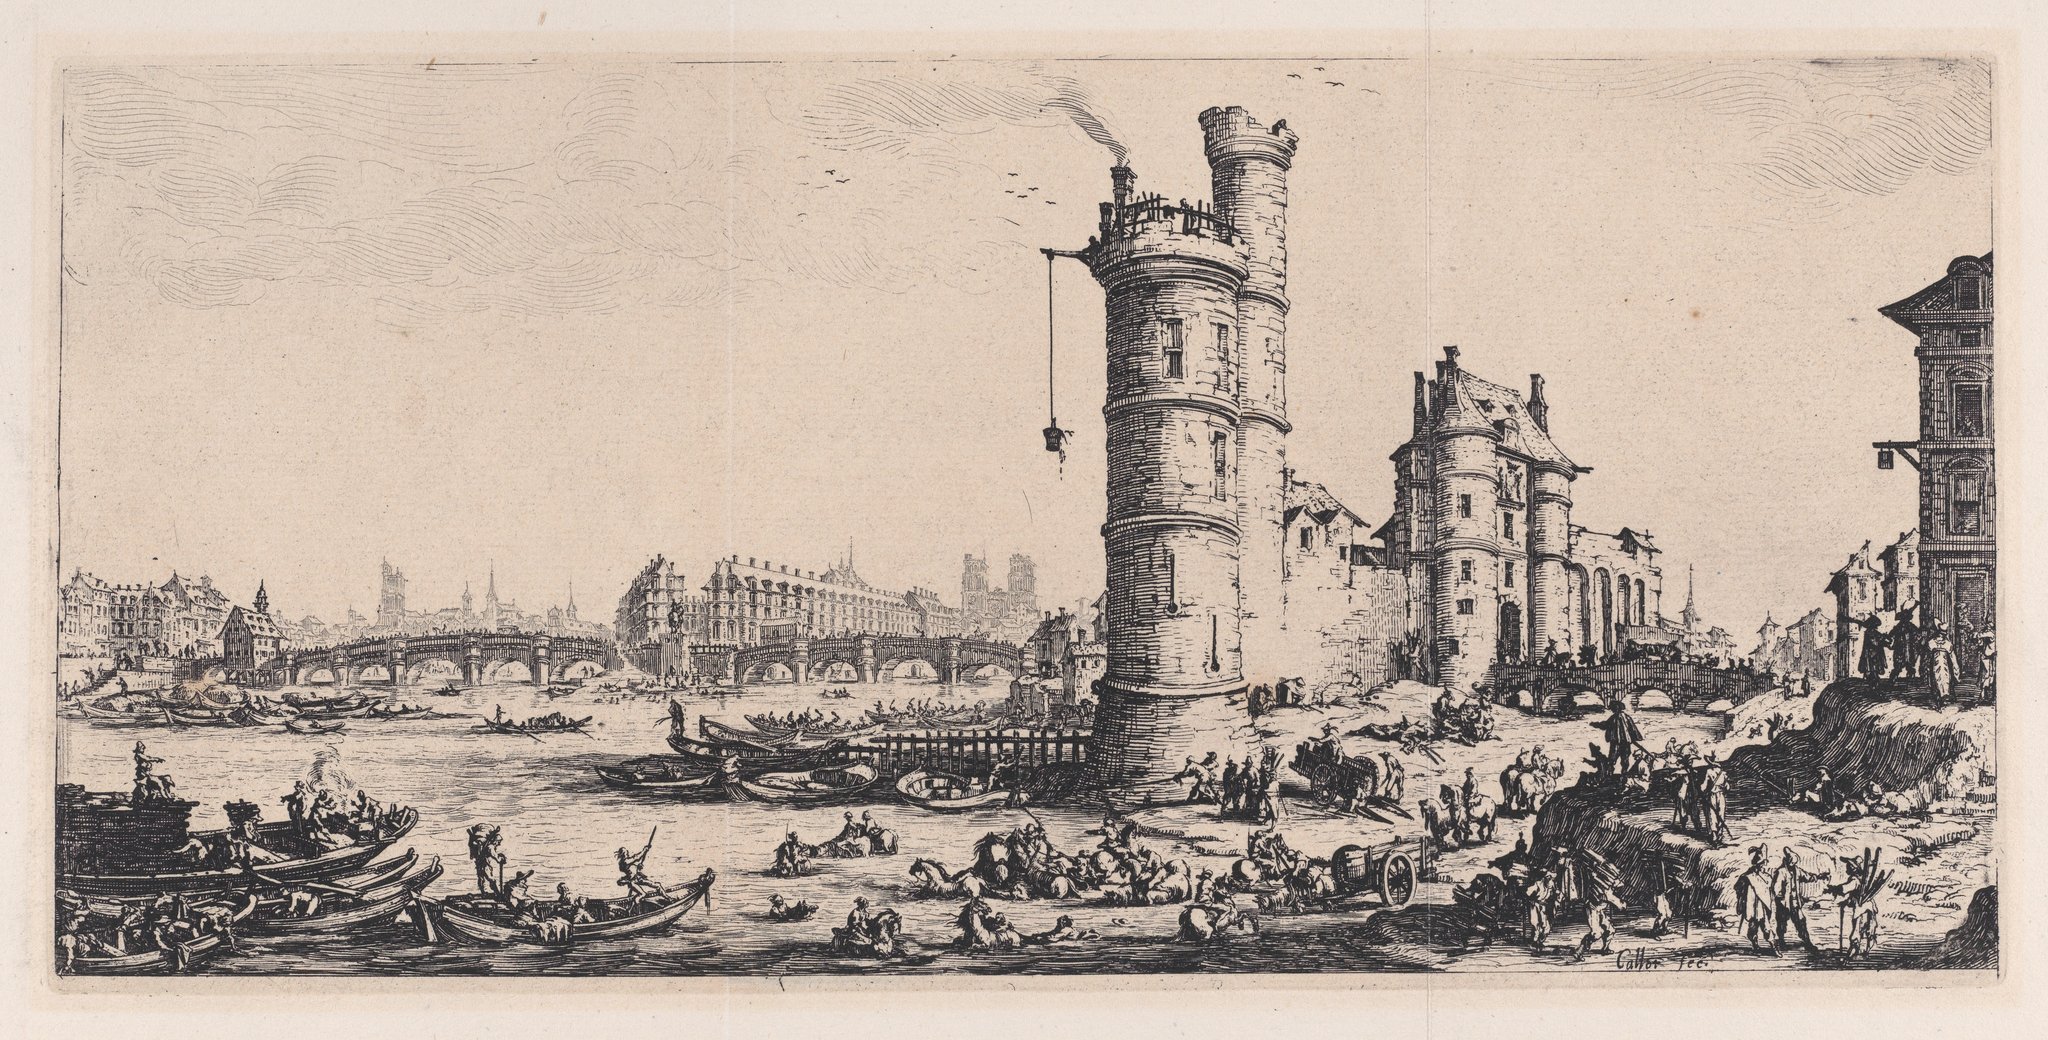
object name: print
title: Vue de Pont-Neuf (View of the Pont-Neuf), from "Les Deux Grandes Vues de Paris" (The Two Large Views of Paris)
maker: jacques callot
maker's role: artist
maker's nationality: french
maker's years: 1592-1635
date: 1630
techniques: etching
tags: towers,rivers,boats,paris